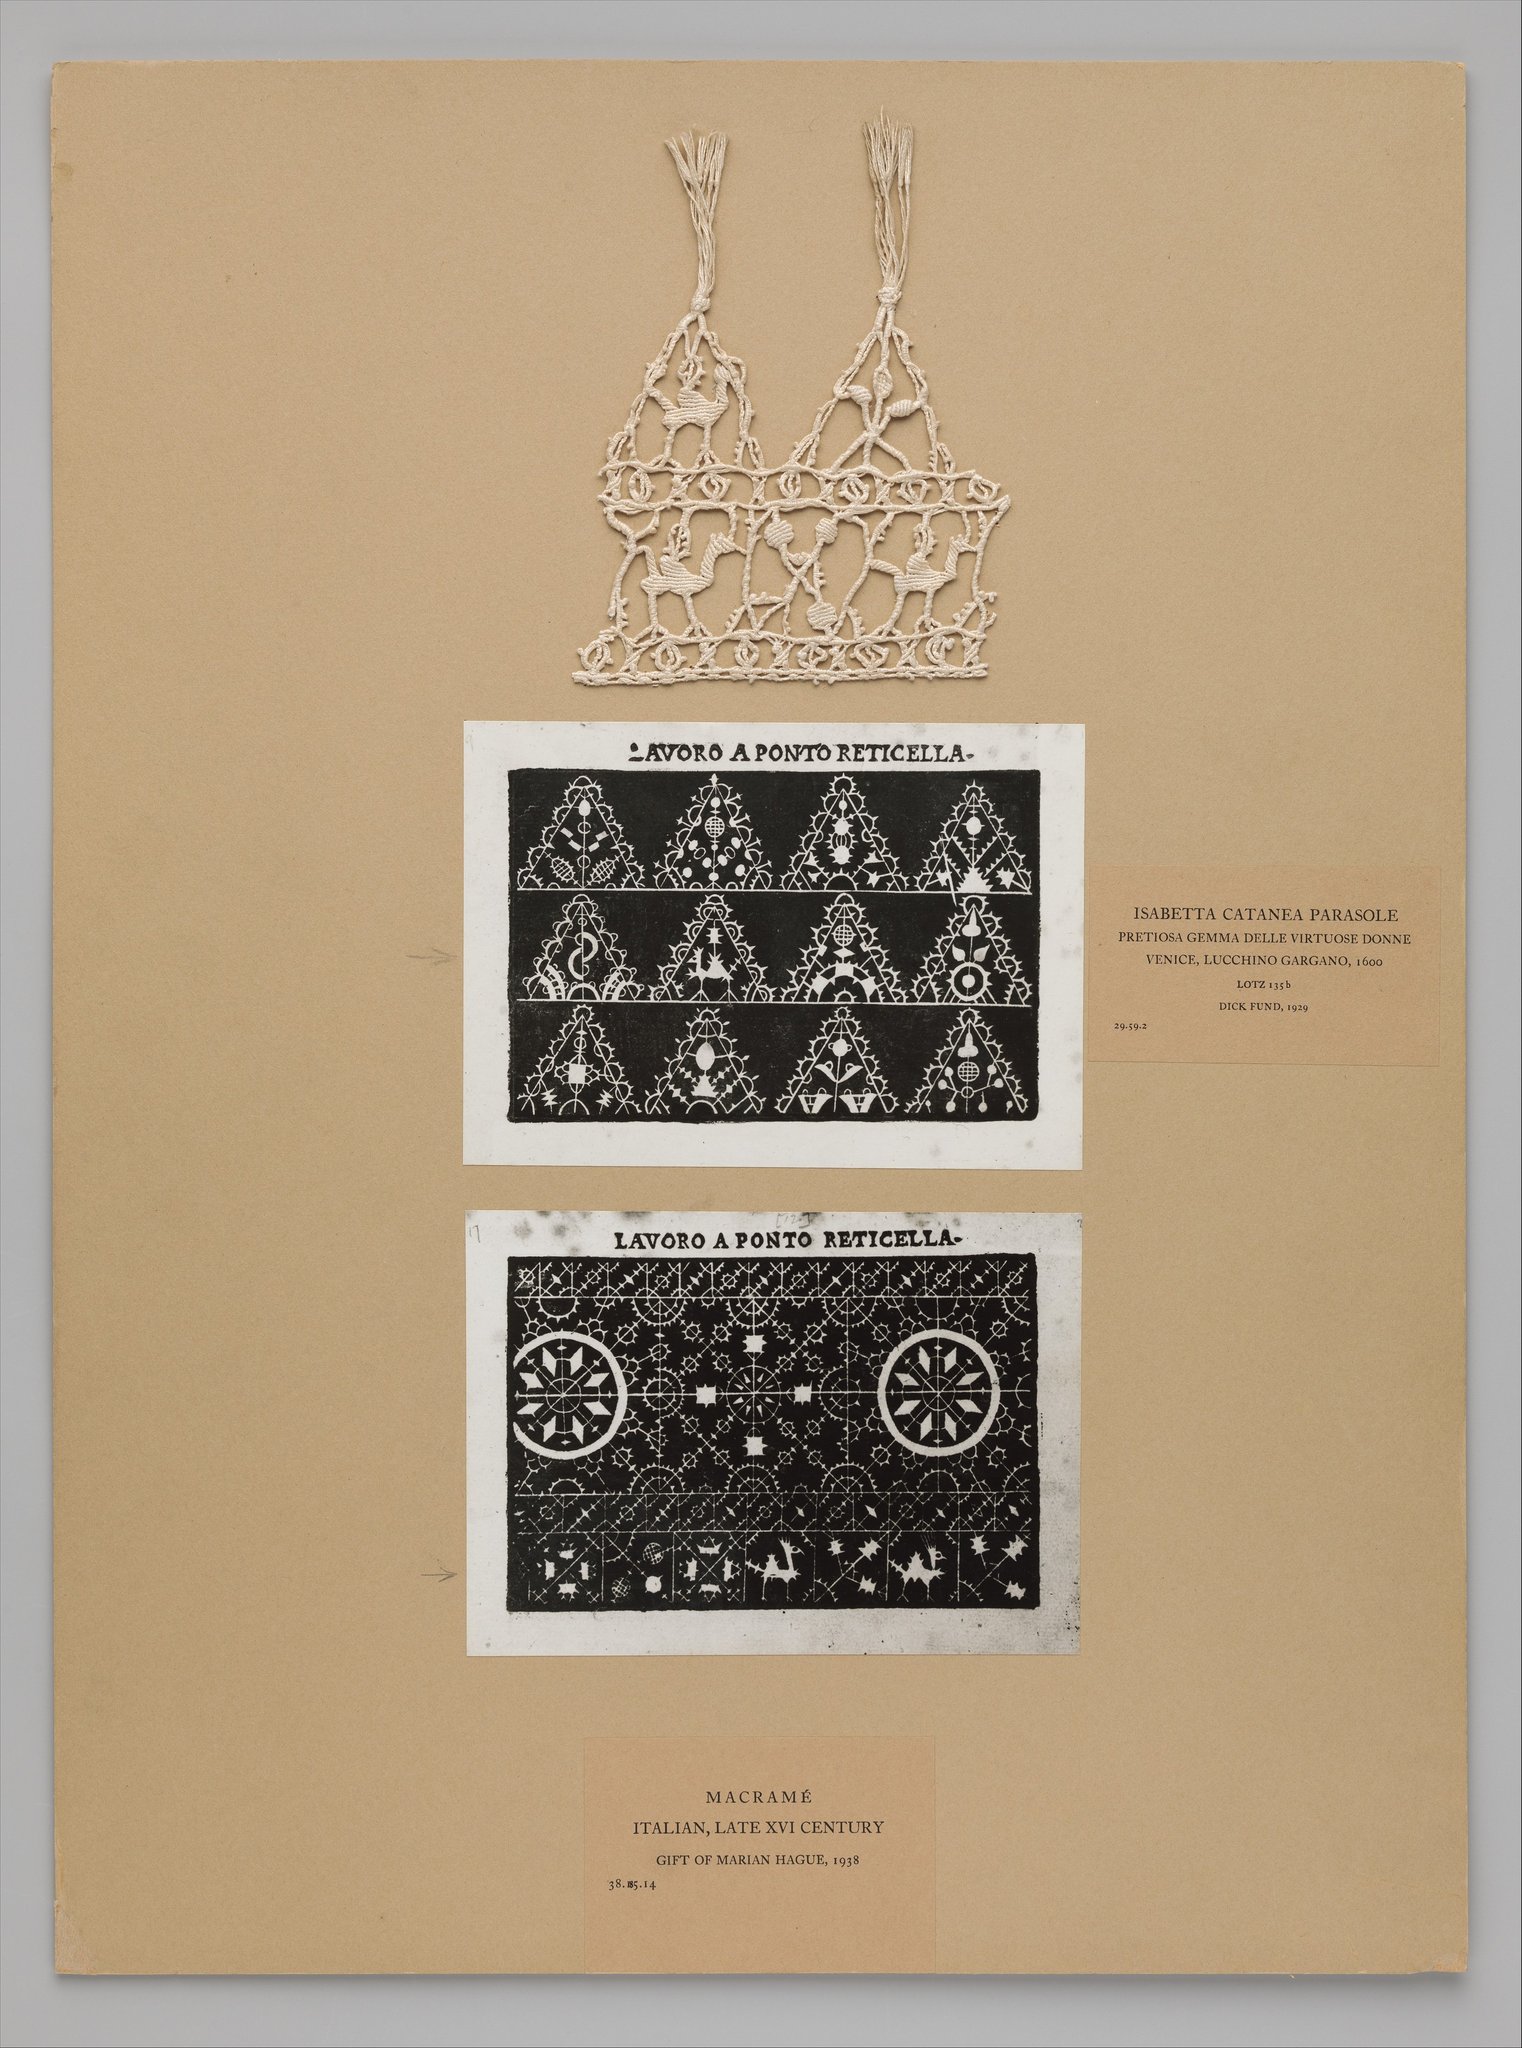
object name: edging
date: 1567-1600